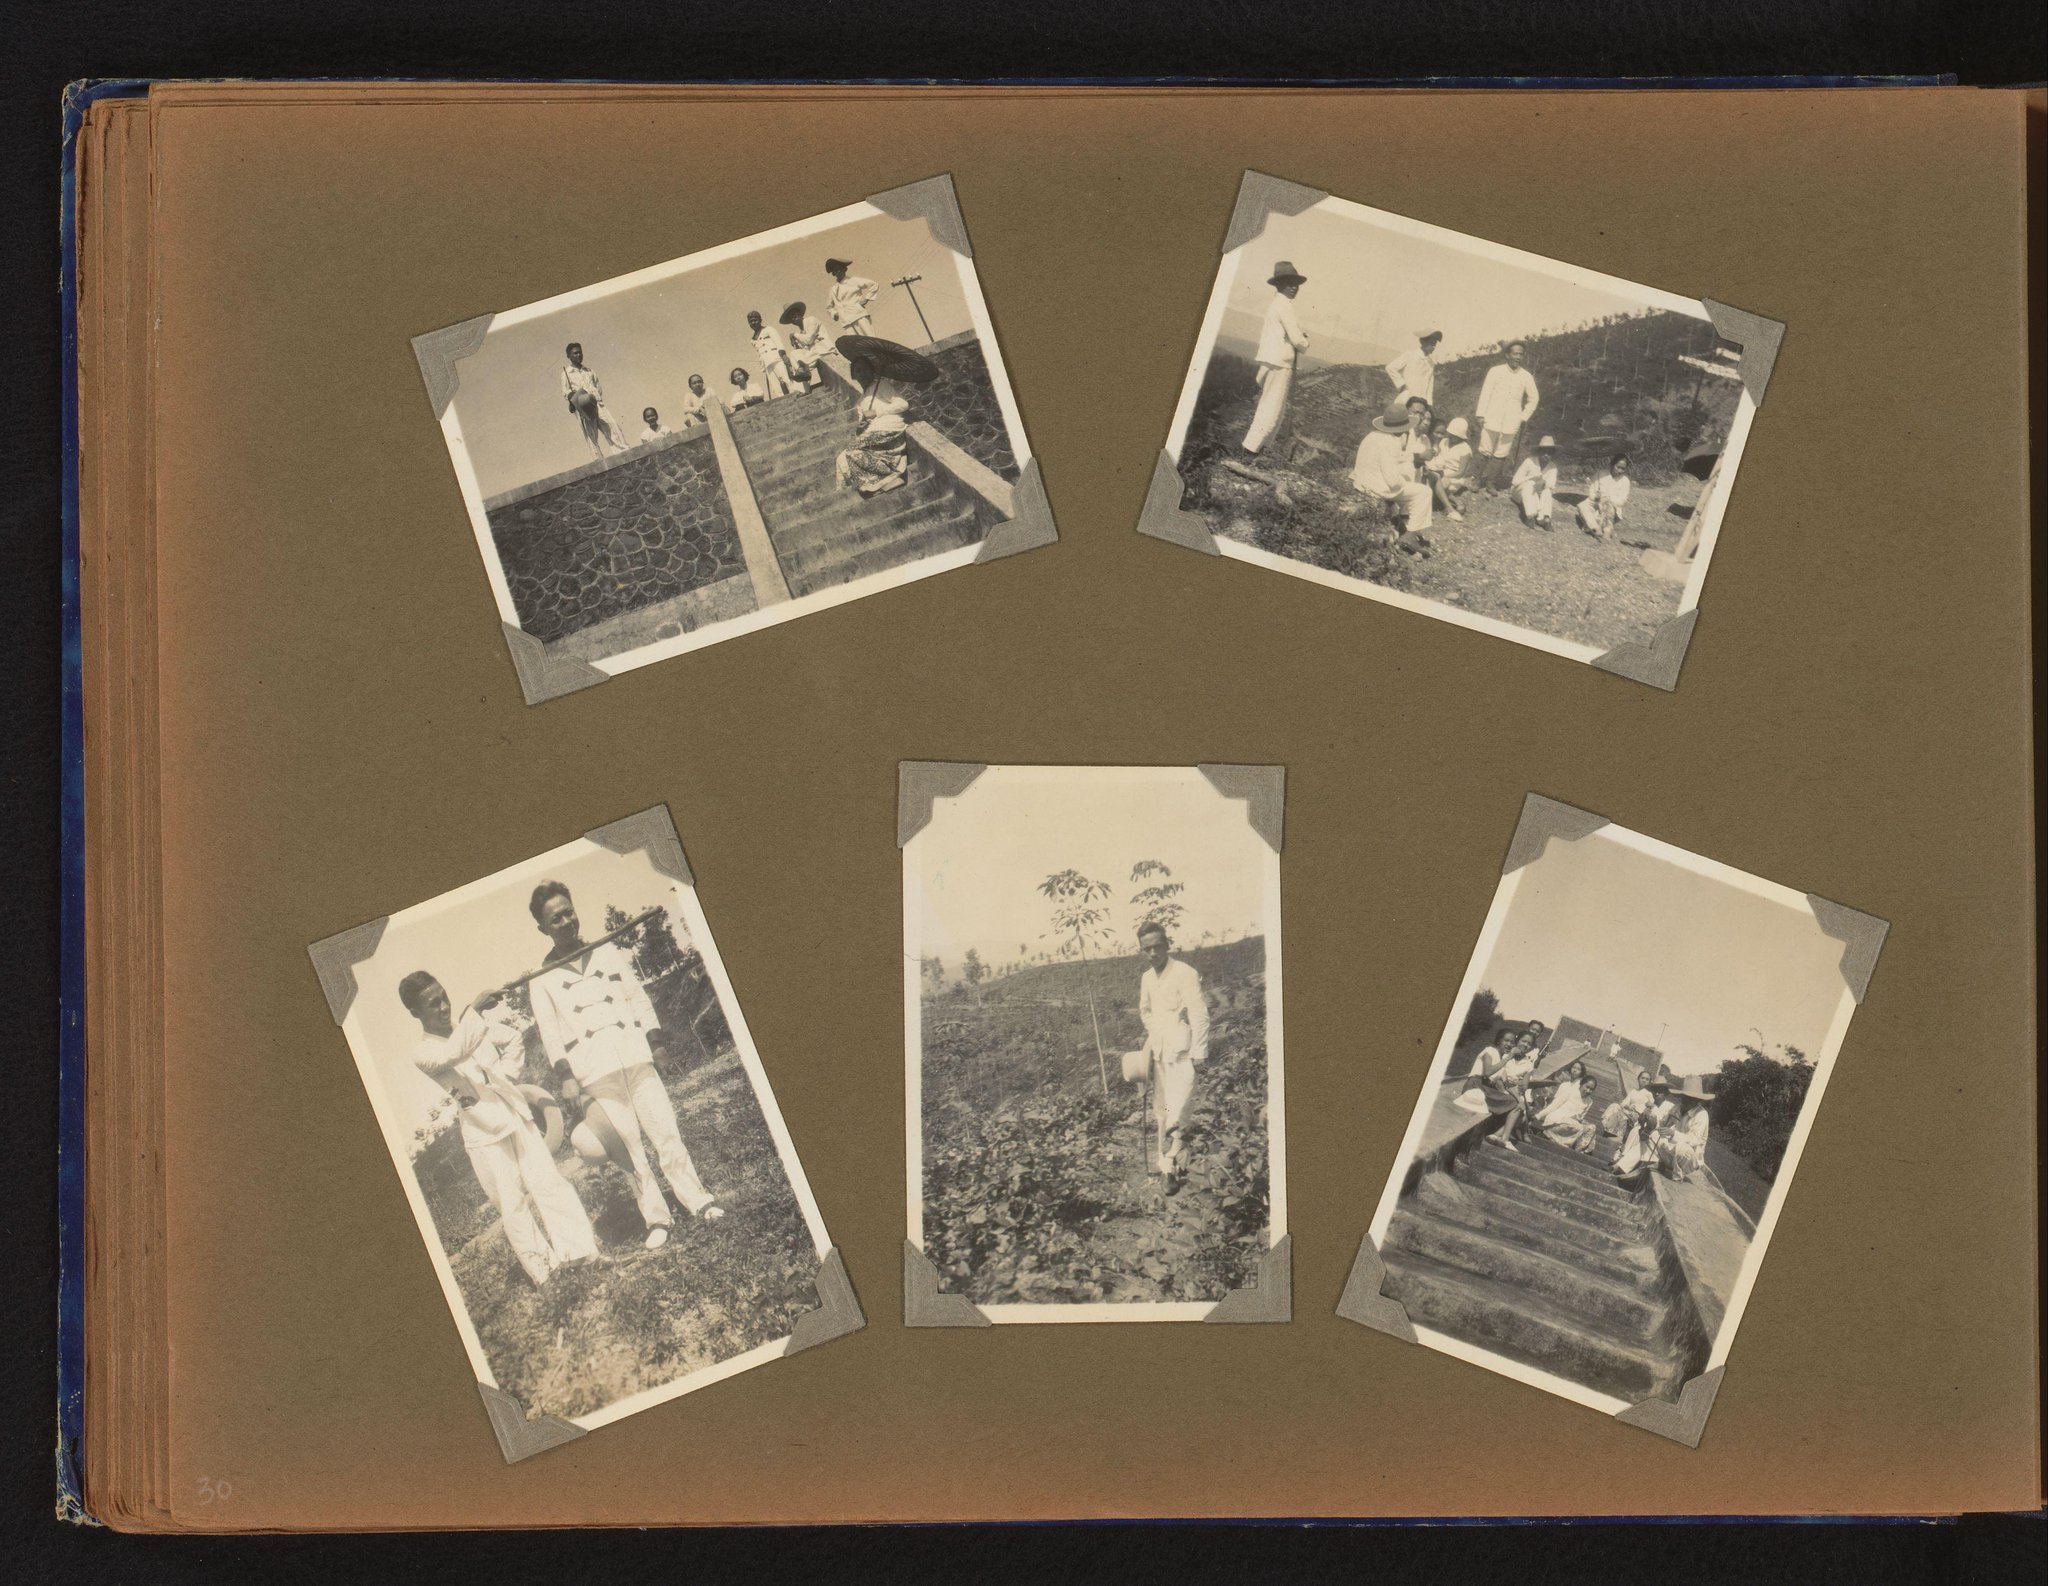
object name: album leaf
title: Uitje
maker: Anonymous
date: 1935-1936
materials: cardboard, photographic support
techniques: gelatin silver print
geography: indonesia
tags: outing, pleasure trip, indonesia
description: Albumblad met vijf foto's van een uitje met een groep, vrienden of leden van Chung-Hsiok. Onderdeel van een familiealbum van een Chinees-Indische familie in Weltevreden, ca. 1935.